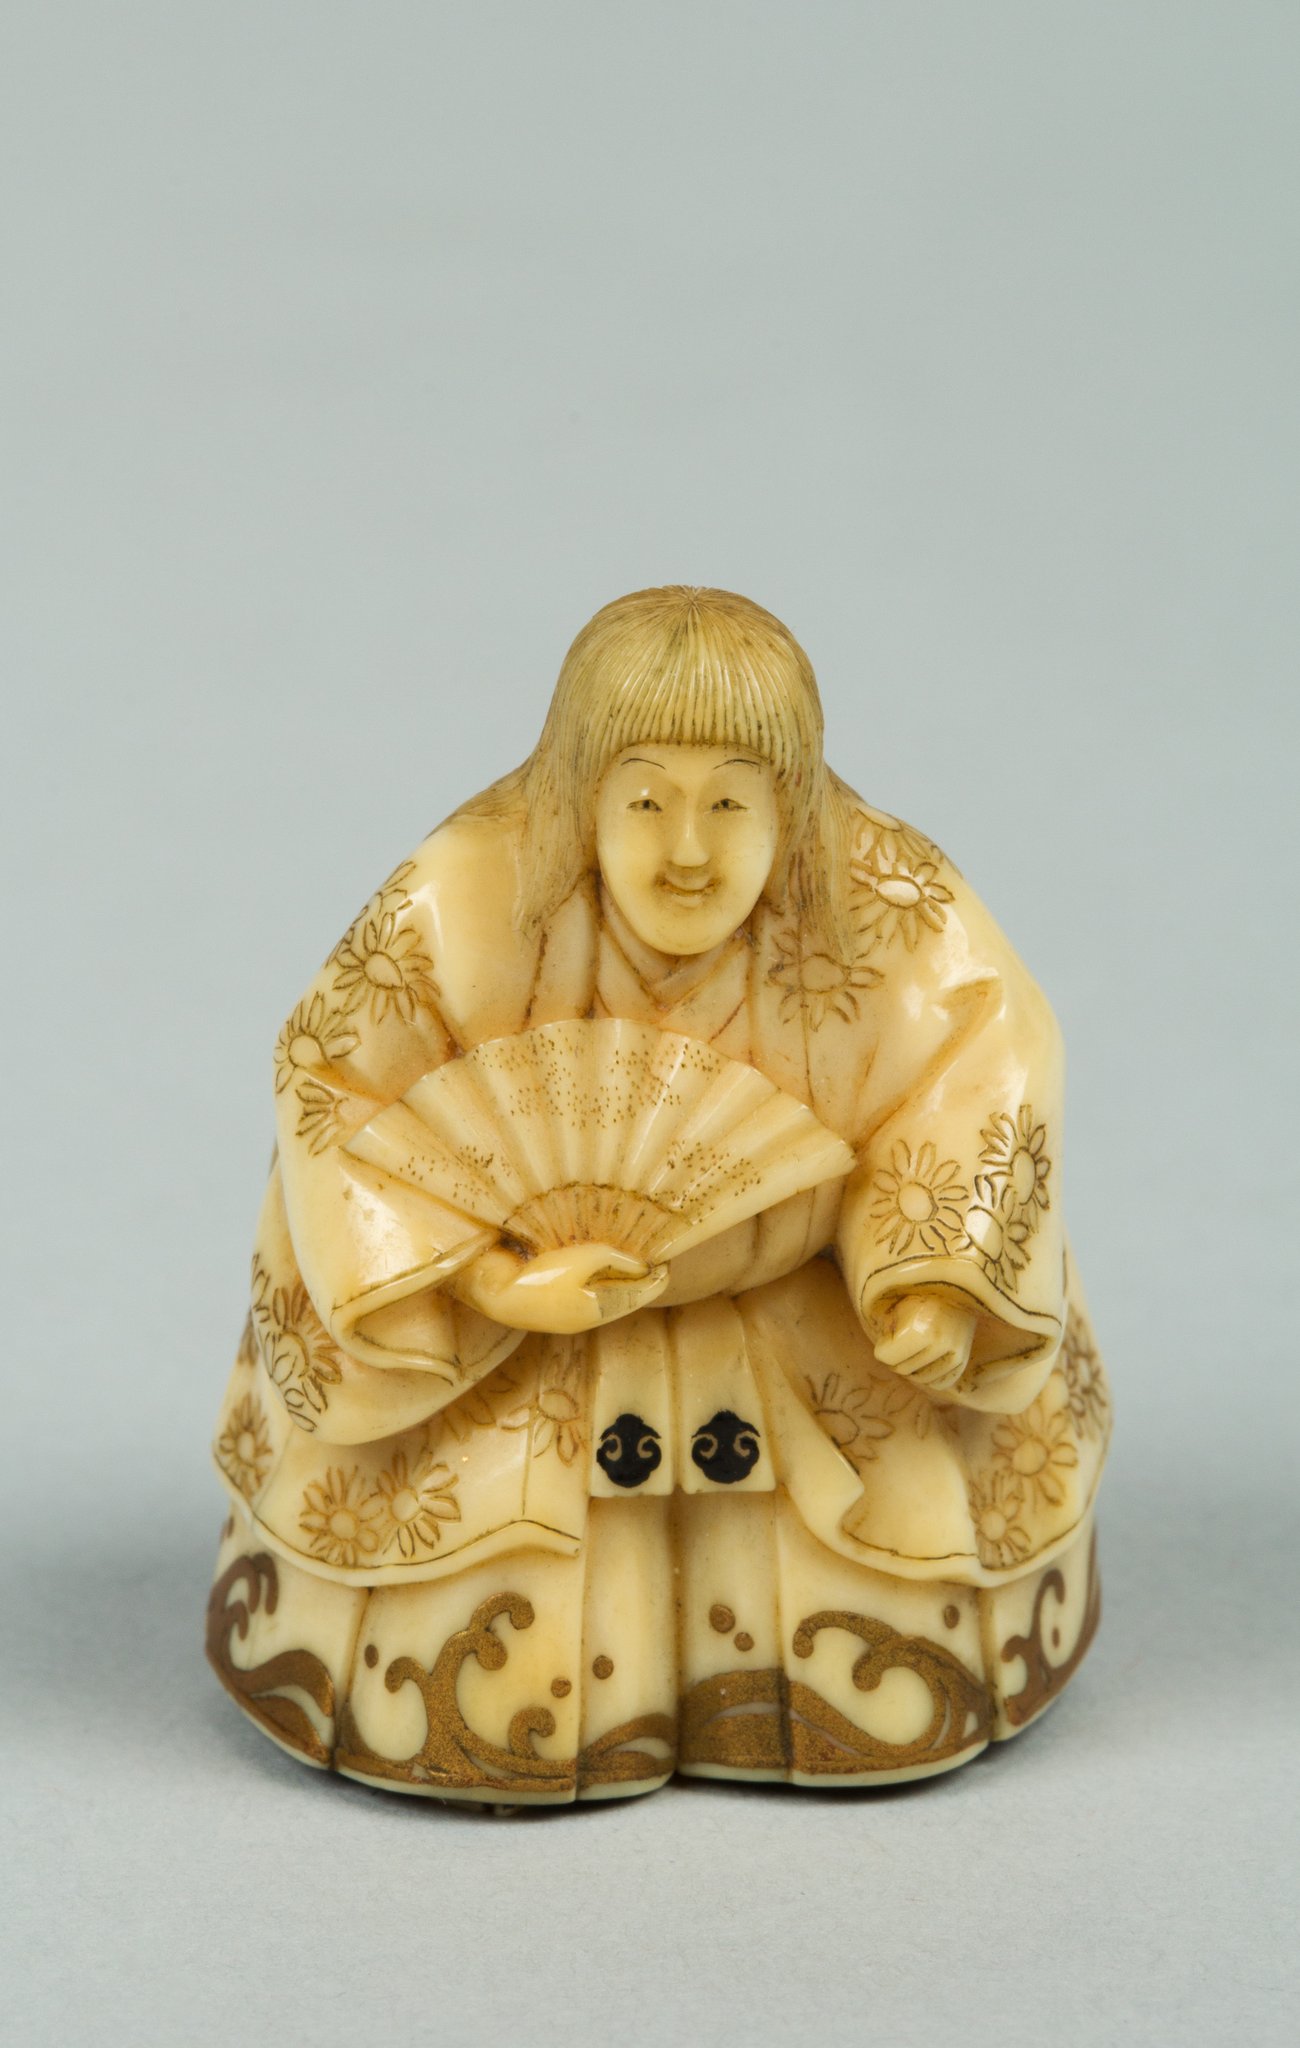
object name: netsuke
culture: japanese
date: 1801-1900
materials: gold, ivory, lacquer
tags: fans